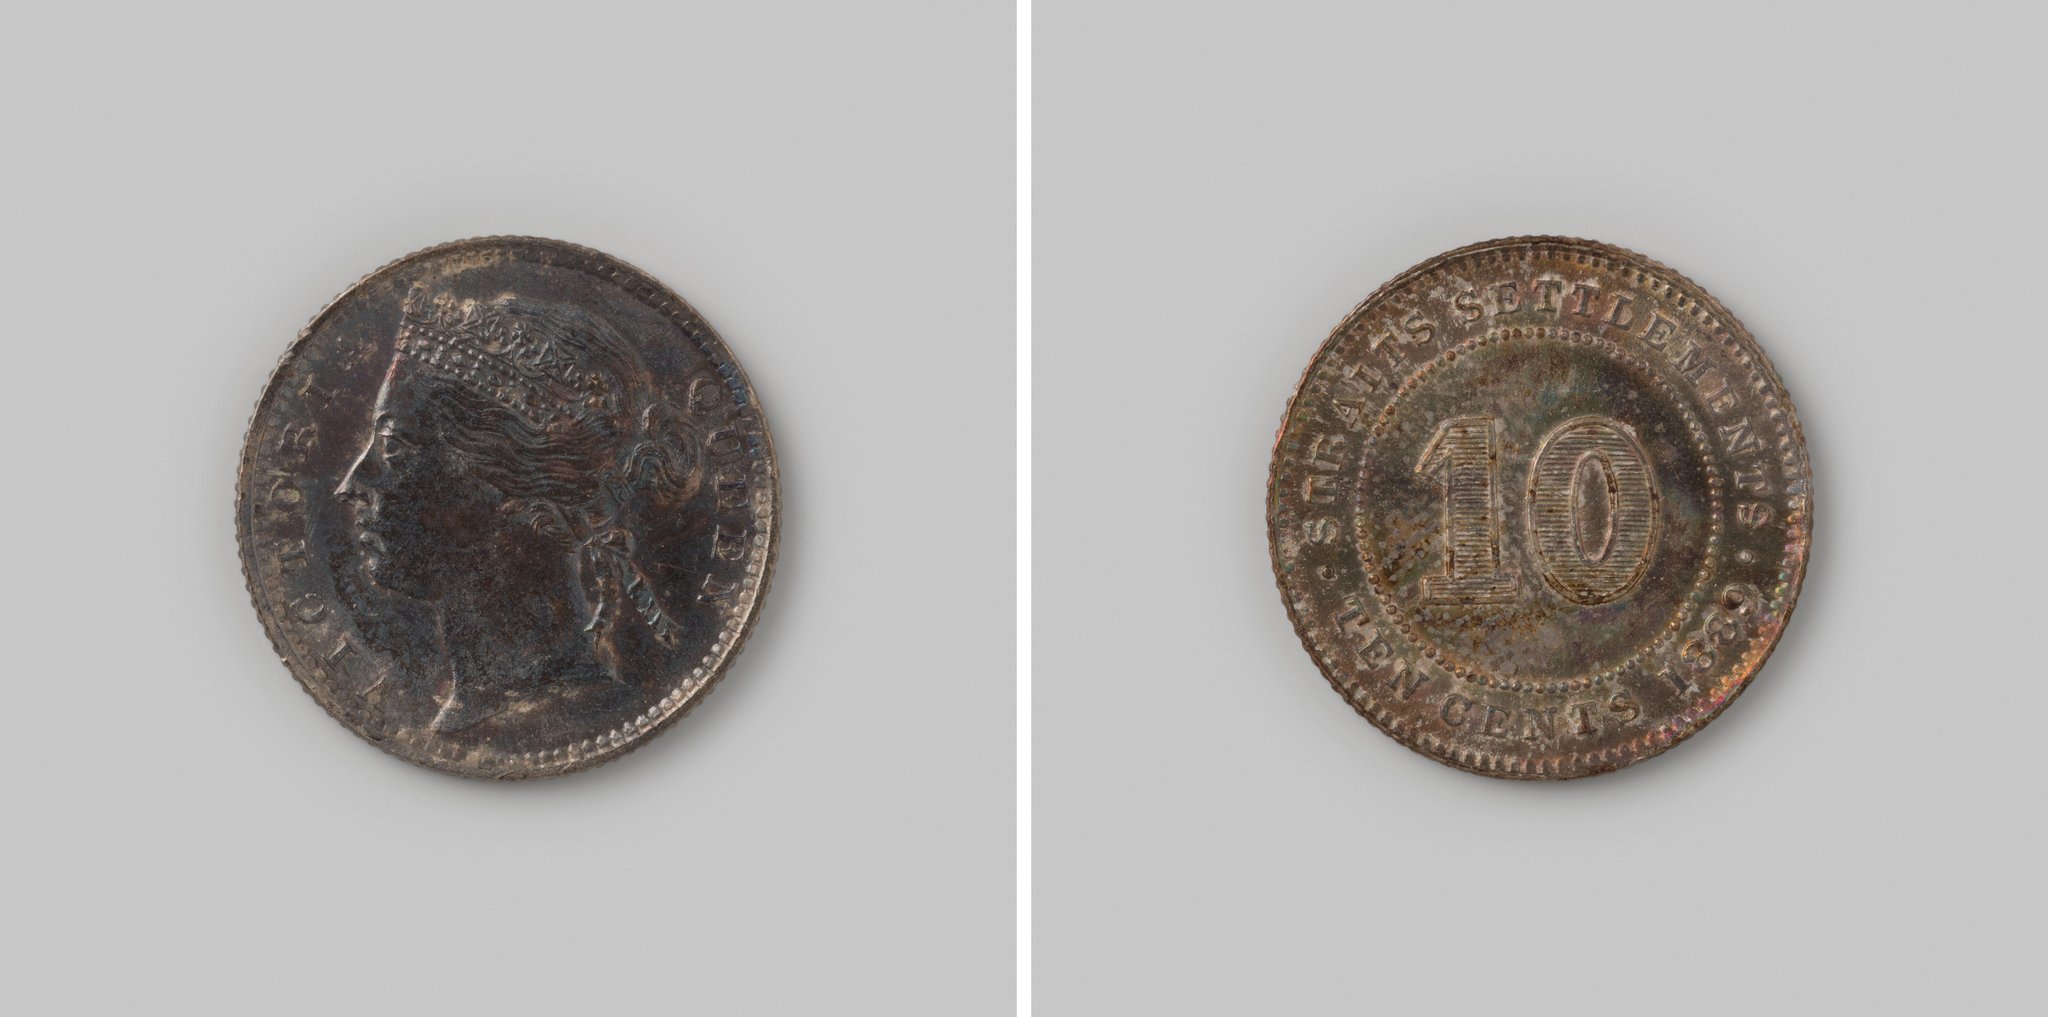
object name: coin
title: 10 cents uit de Straits Settlements van koningin Victoria, 1895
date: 1895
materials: silver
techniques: striking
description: Zilveren munt. Voorzijde: gekroond hoofd van koningin Victoria naar links. Keerzijde: binnen parelcirkel waarde-aanduiding: 10. In omschrift onderaan waarde-aanduiding: ten cents met rechts daarvan jaartal. Kartelrand.